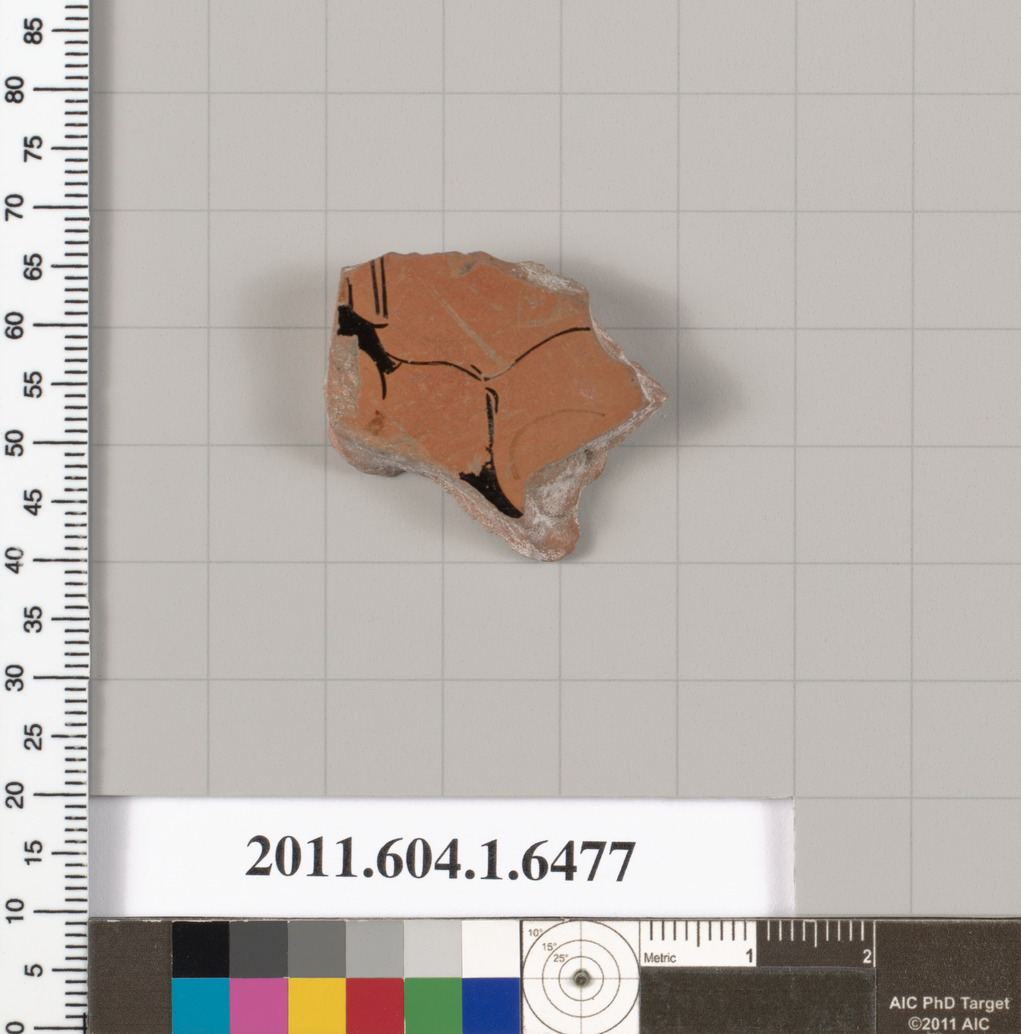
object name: kylix fragment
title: Terracotta fragment of a kylix (drinking cup)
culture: greek, attic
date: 490-480 BCE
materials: terracotta